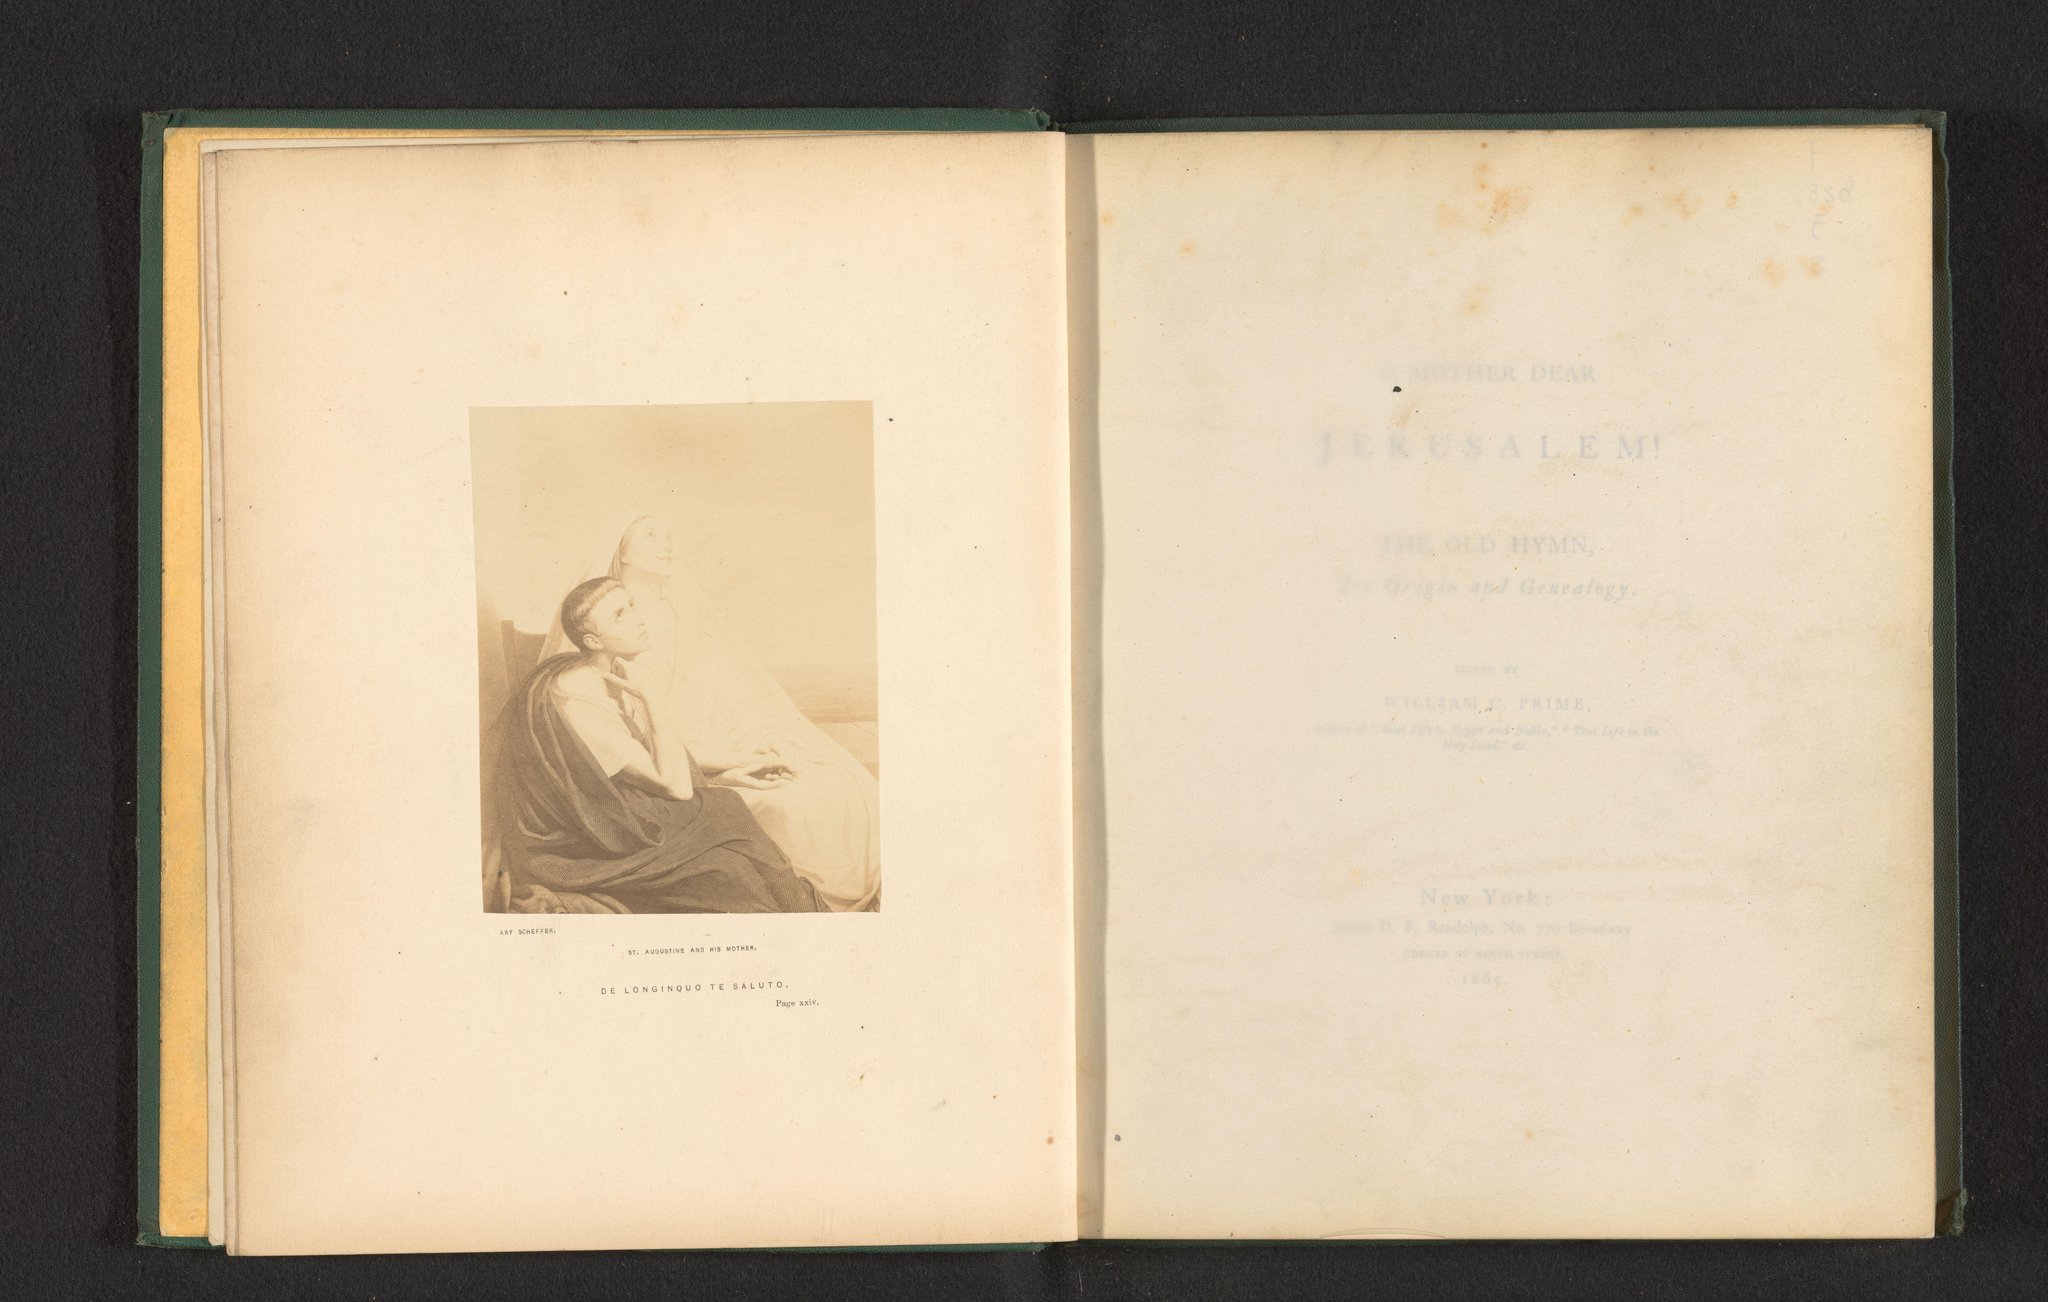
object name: reproduction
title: St. Augustine and his mother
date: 1860-1865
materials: photographic support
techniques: albumen print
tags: augustine, bishop of hippo; possible attributes: arrows piercing his breast, book, child with spoon, flaming heart, heart (pierced with arrows), pen, the mother of augustine, monica of tagaste (or ostia); possible attributes: black dress with white veil or wimple, book, crucifix, rosary